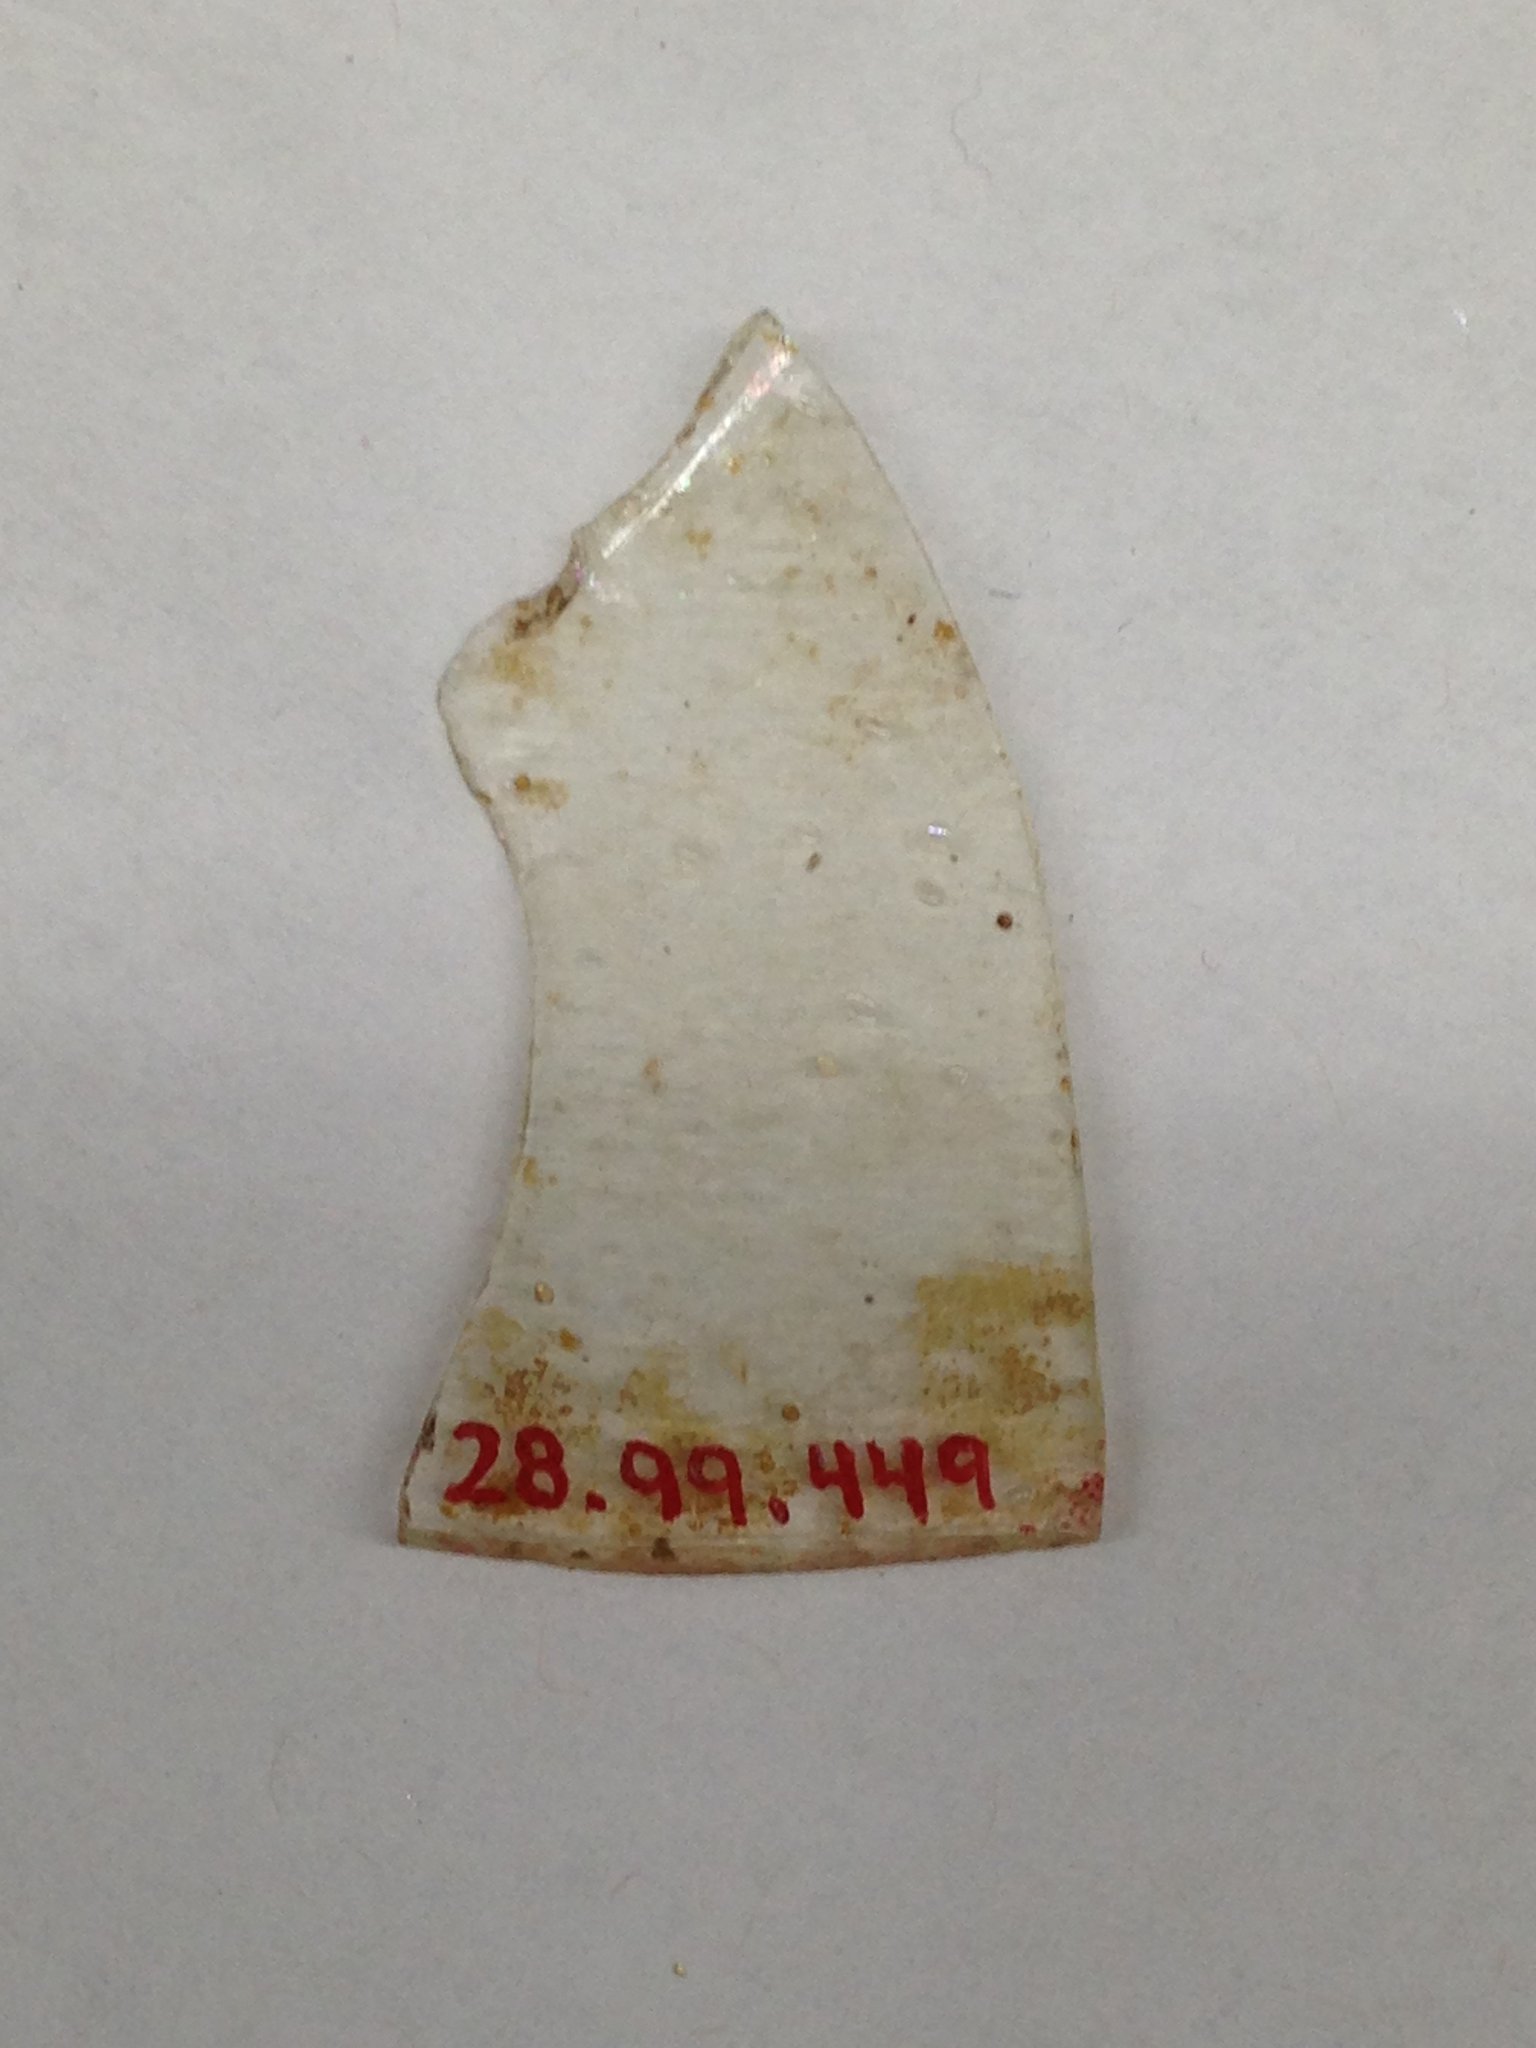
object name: fragment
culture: european or middle eastern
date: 1150-1250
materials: ceramic, glass